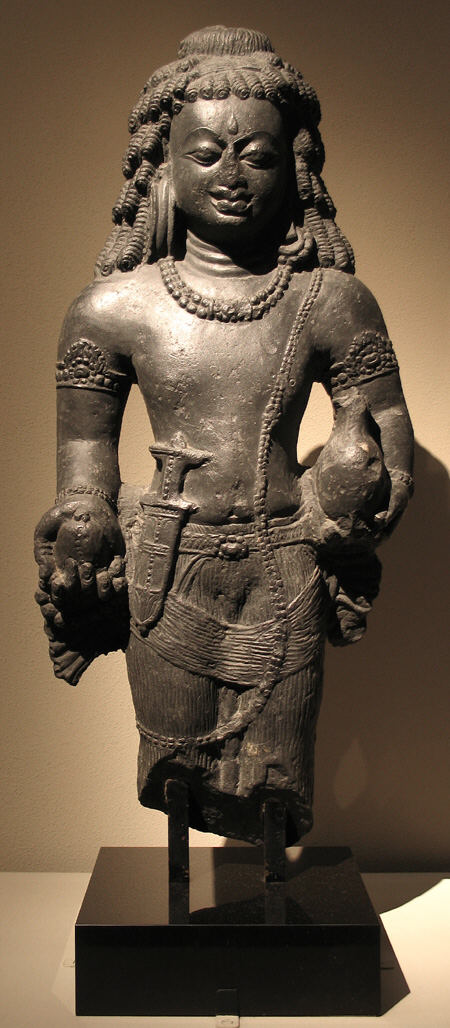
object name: figure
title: Standing Male Deity (possibly Shiva)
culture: indian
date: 501-600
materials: stone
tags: post-gupta,men